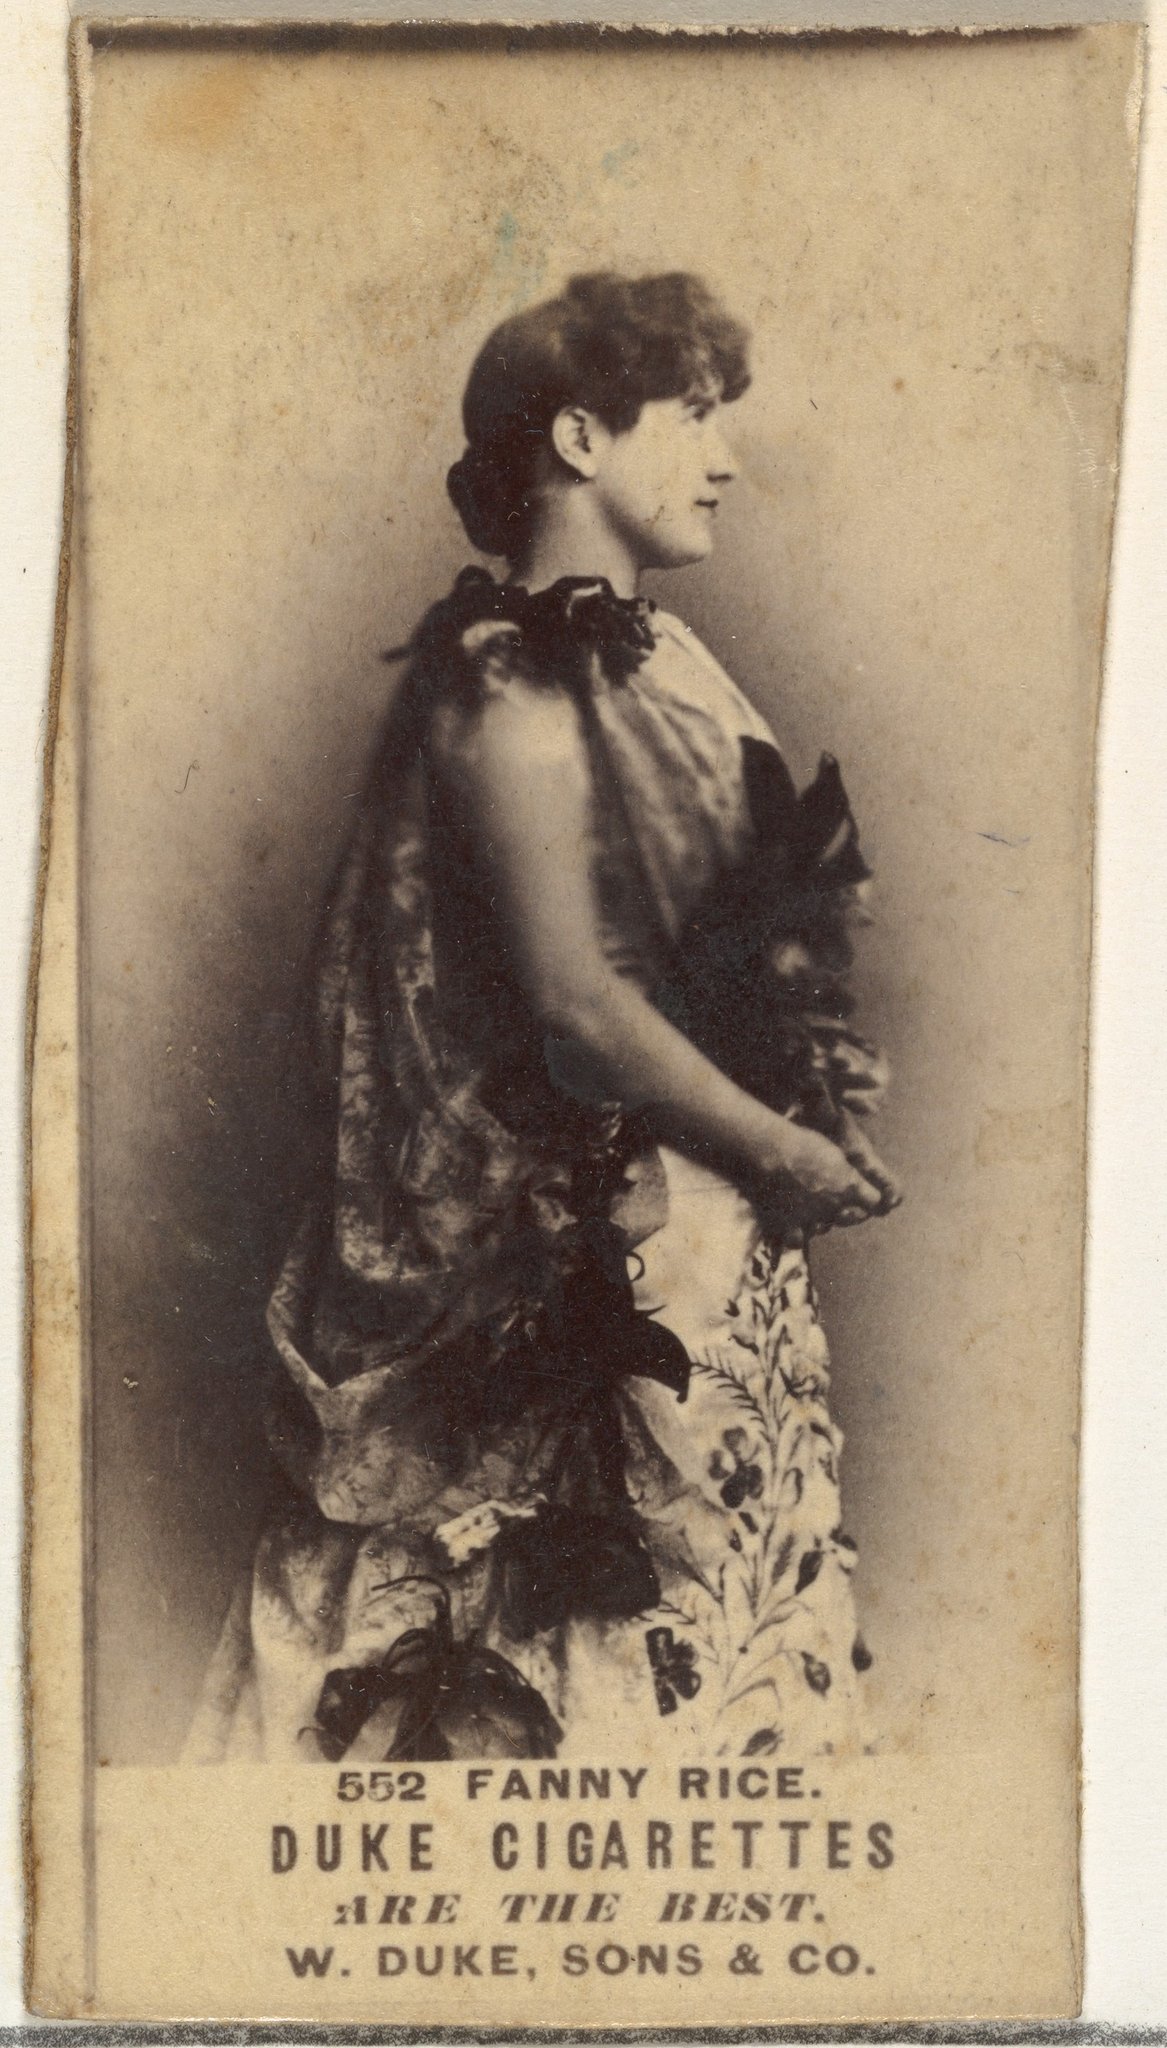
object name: photograph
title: Card Number 552, Fanny Rice, from the Actors and Actresses series (N145-7) issued by Duke Sons & Co. to promote Duke Cigarettes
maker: w. duke, sons & co.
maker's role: publisher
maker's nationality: american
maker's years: 1870-1920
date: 1880-1889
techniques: albumen silver print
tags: women,actresses